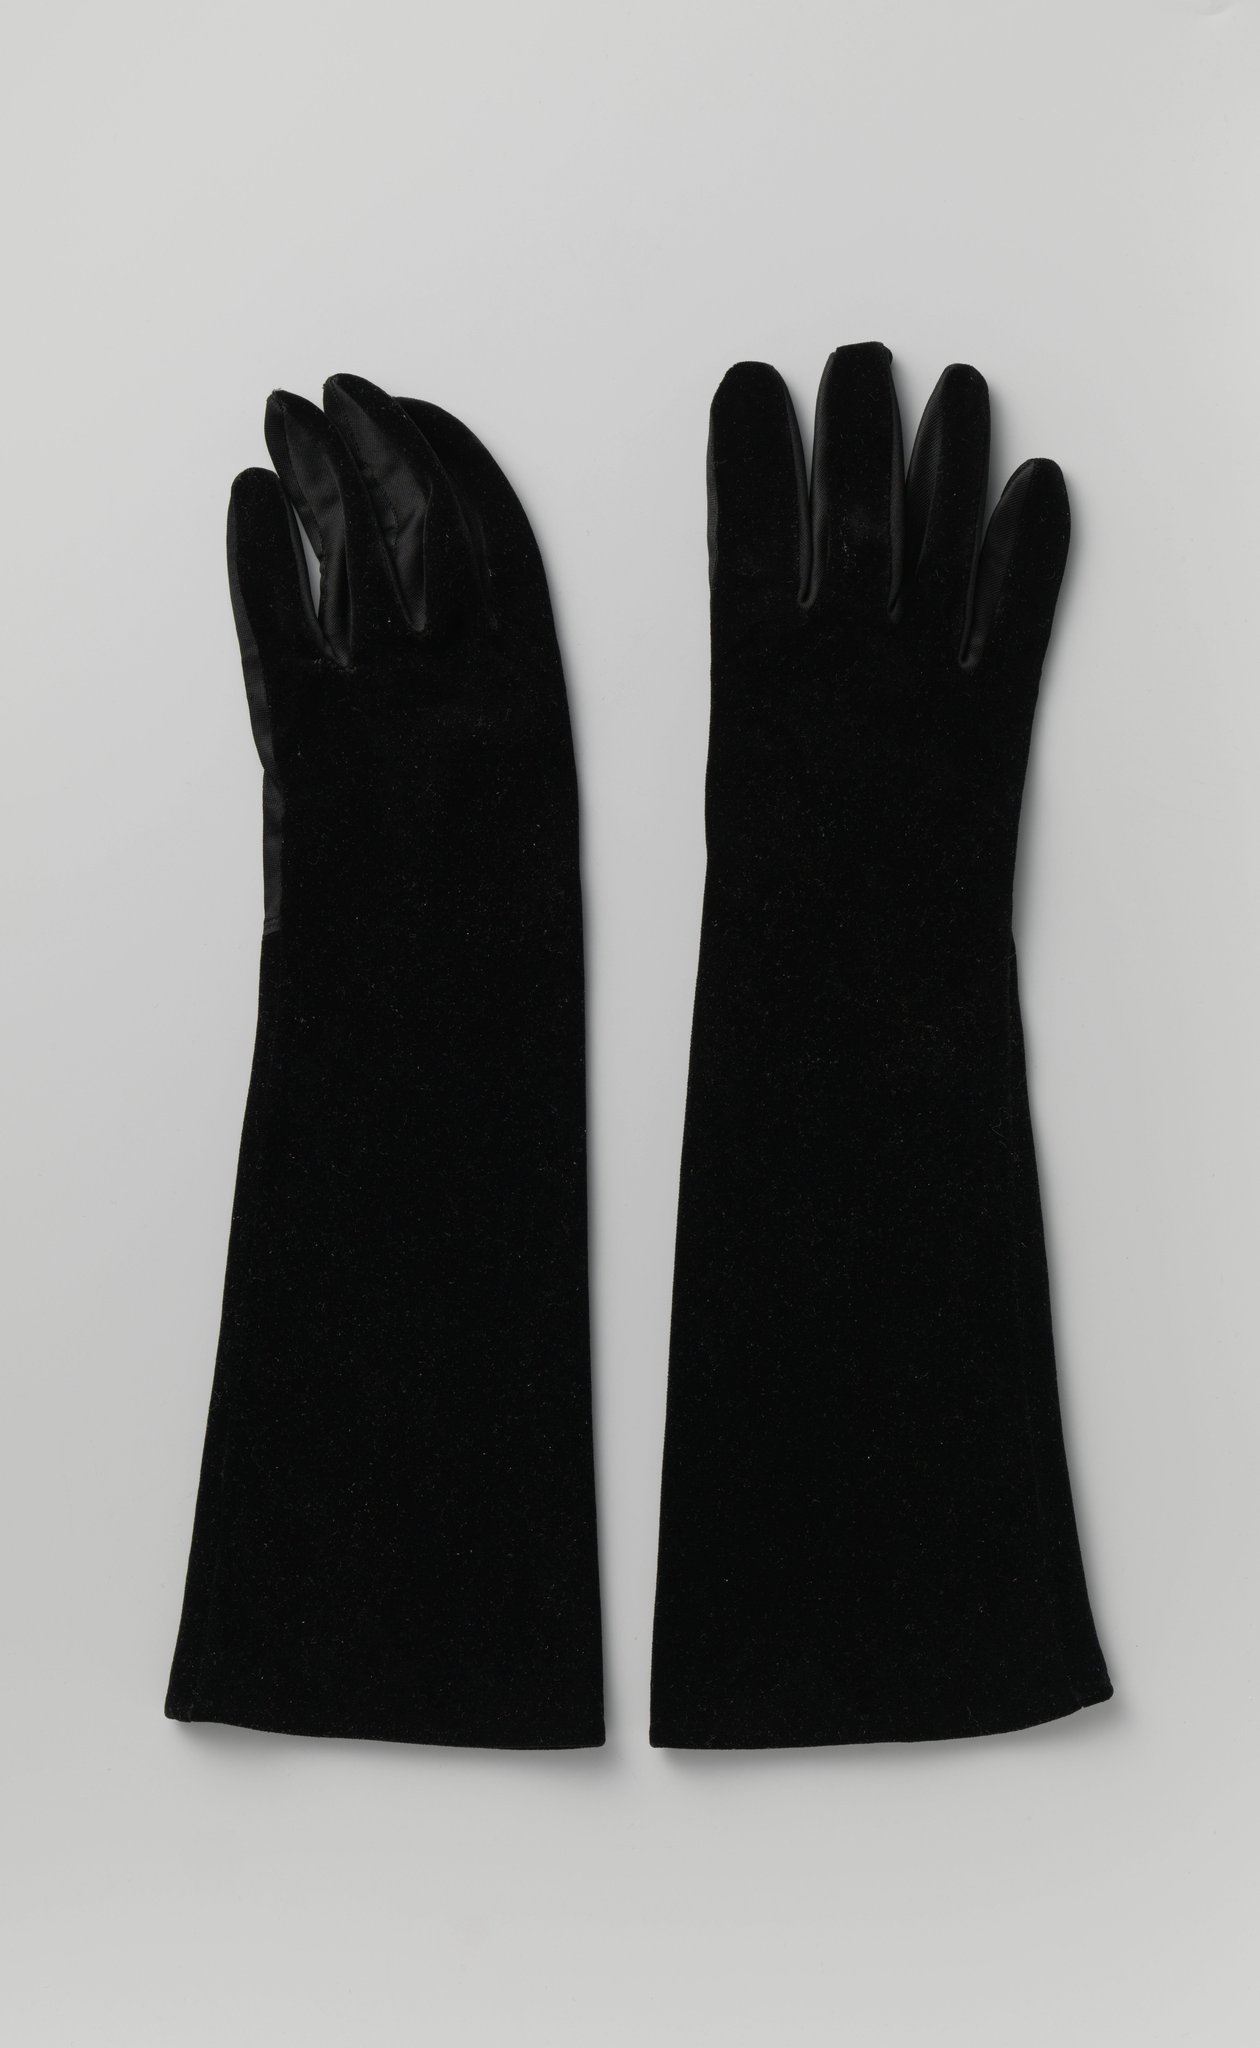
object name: glove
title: Handschoen van zwart fluweel met vingers en handpalm van zwart satijn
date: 1950-1960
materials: textile, velvet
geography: paris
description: Linker handschoenen van zwart fluweel, vingers en handpalm van zwart satijn.